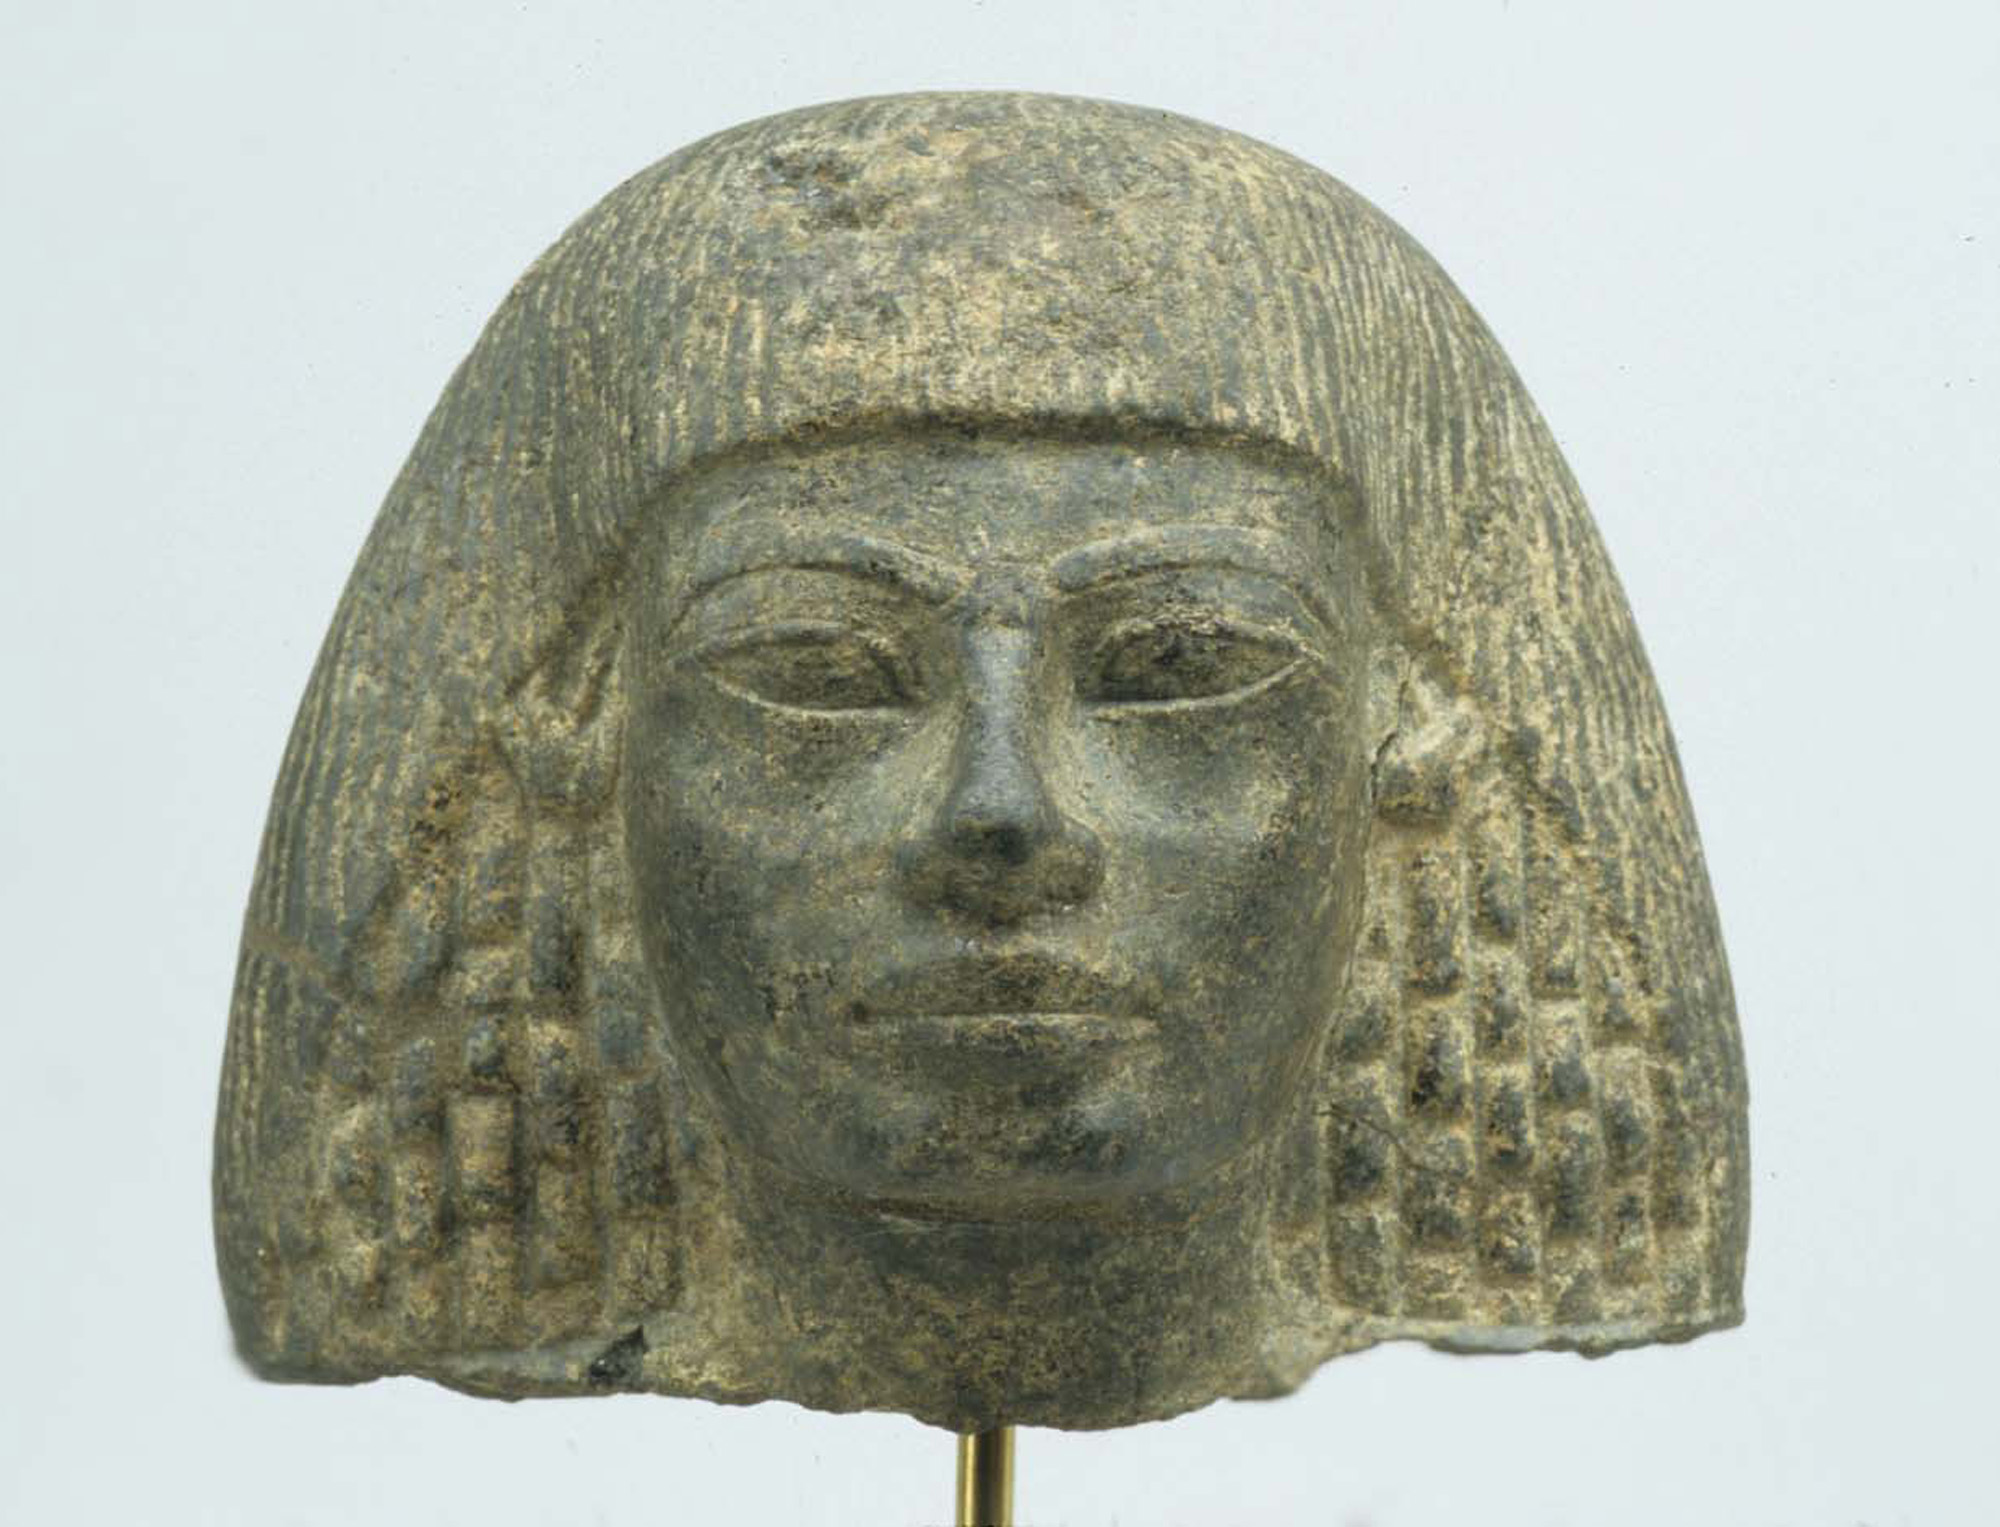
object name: head, official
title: Head of an Official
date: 1390-1352 BCE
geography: egypt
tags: heads,men